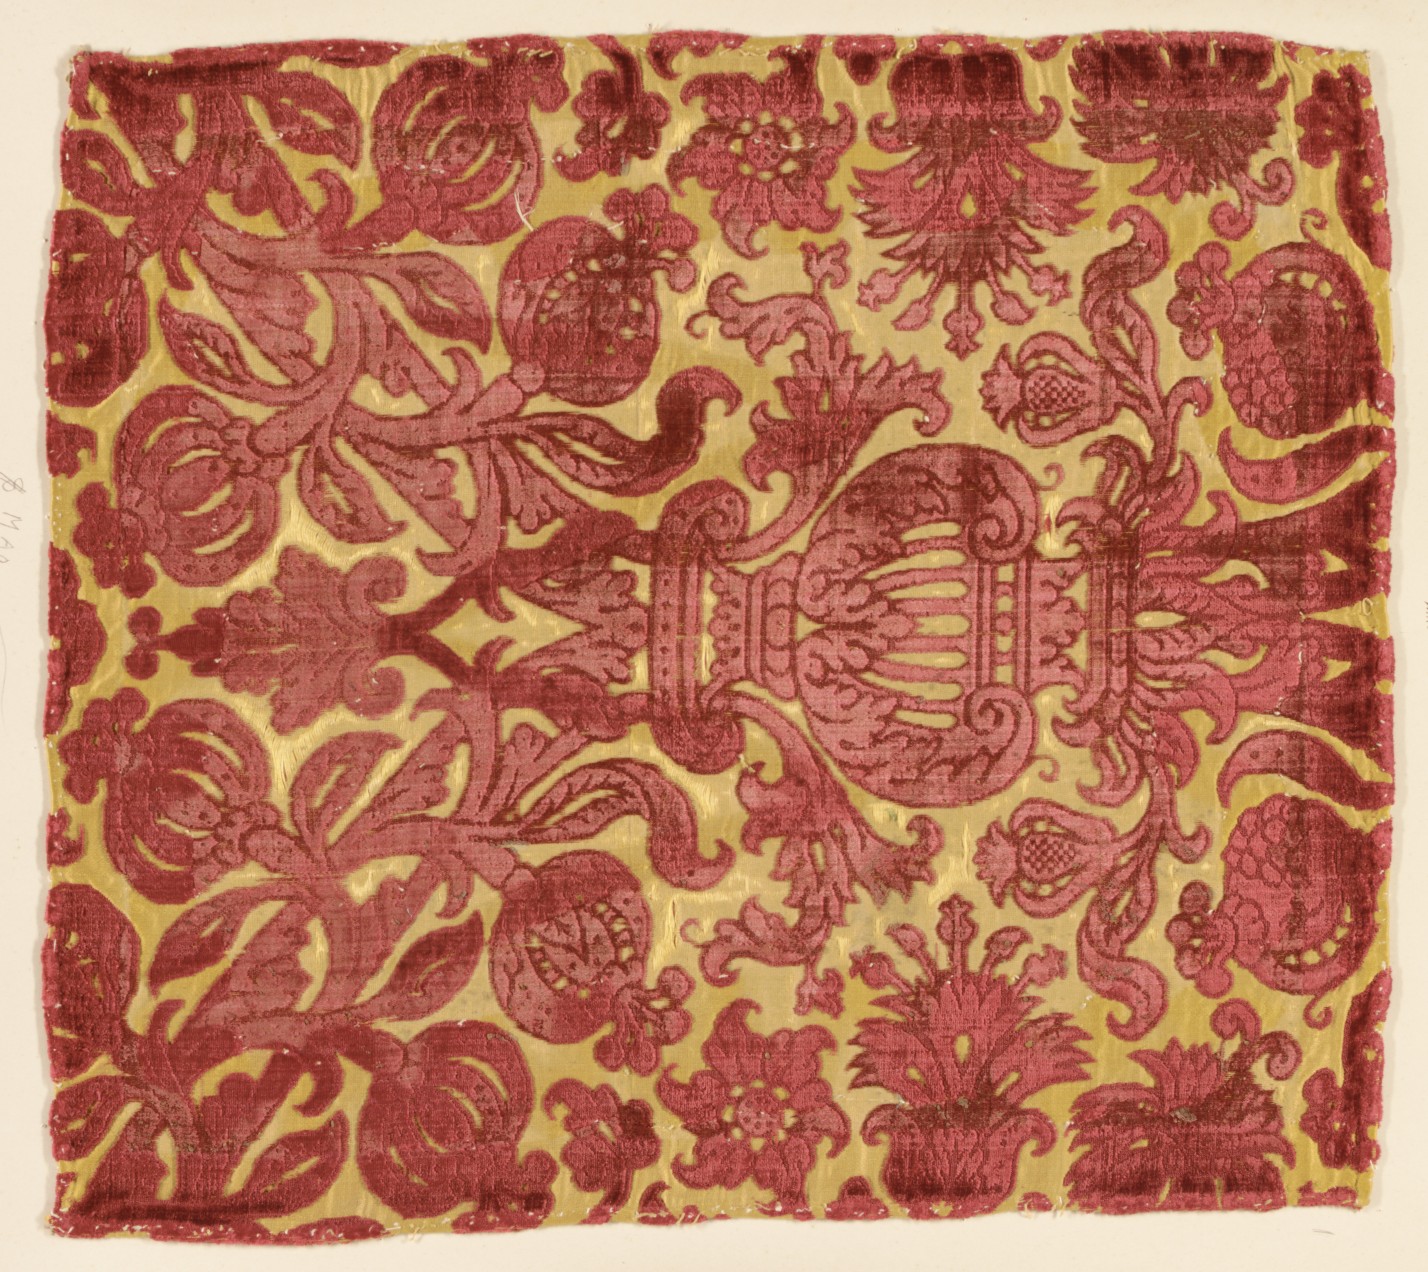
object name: fragment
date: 1601-1700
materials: silk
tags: flowers,leaves